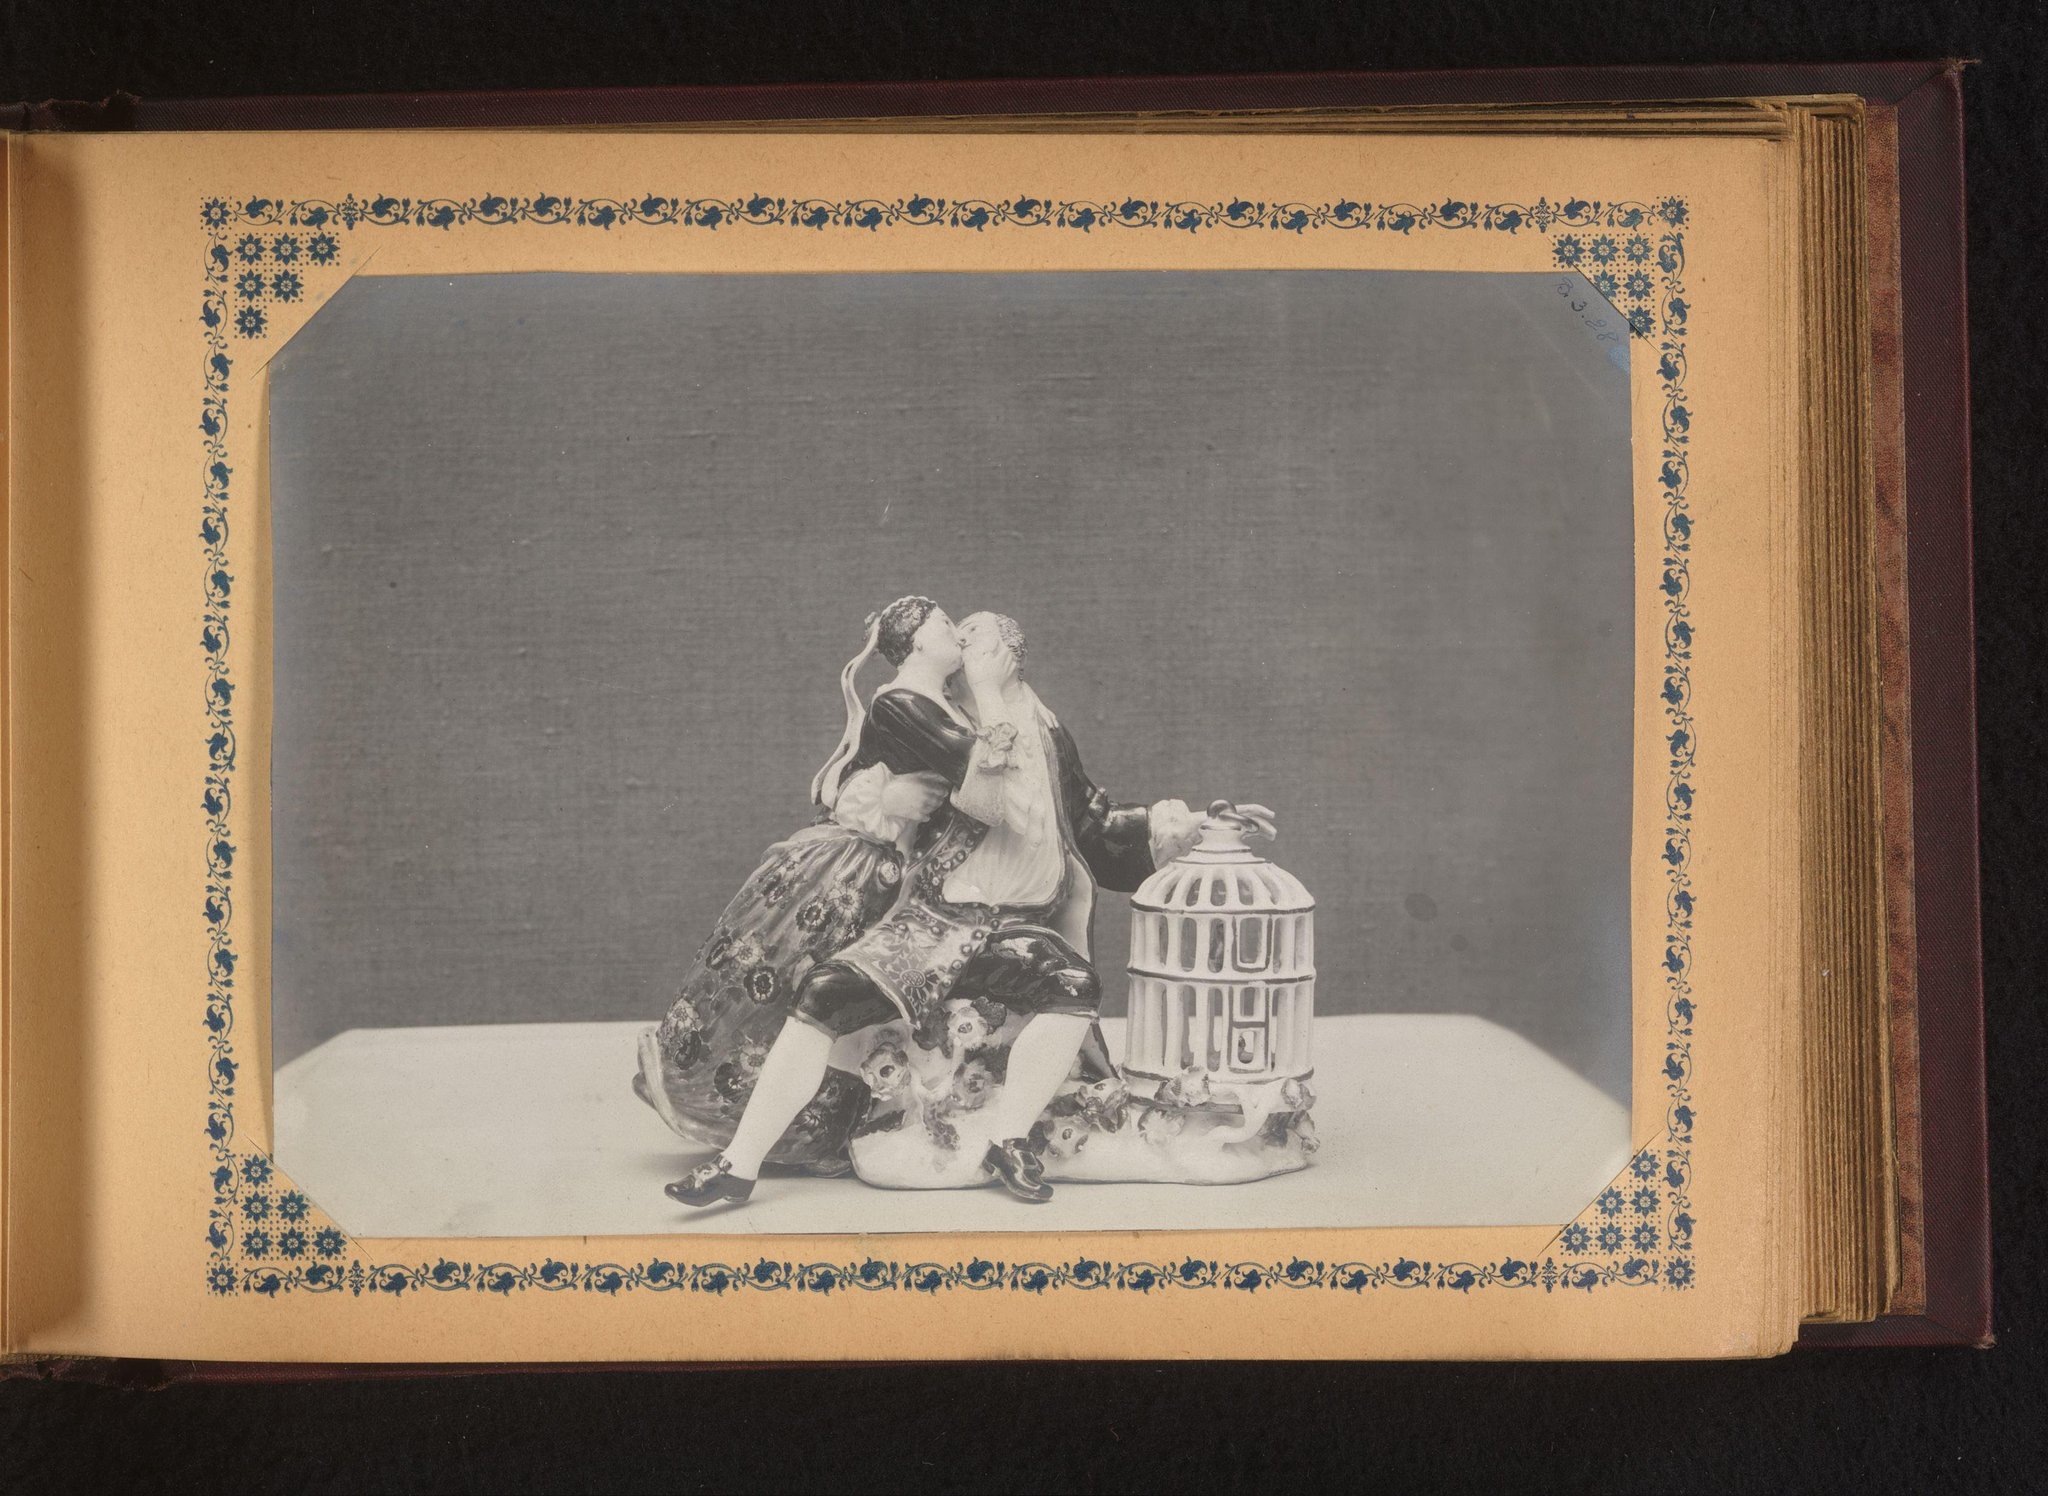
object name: album leaf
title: Sculptuur van een kussend paar en een kooi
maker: Anonymous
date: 1880-1940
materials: cardboard, photographic support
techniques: gelatin silver print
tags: (lovers) kissing each other, piece of sculpture, reproduction of a piece of sculpture, bird in a cage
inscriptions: number: ‘B. 3. 28.’